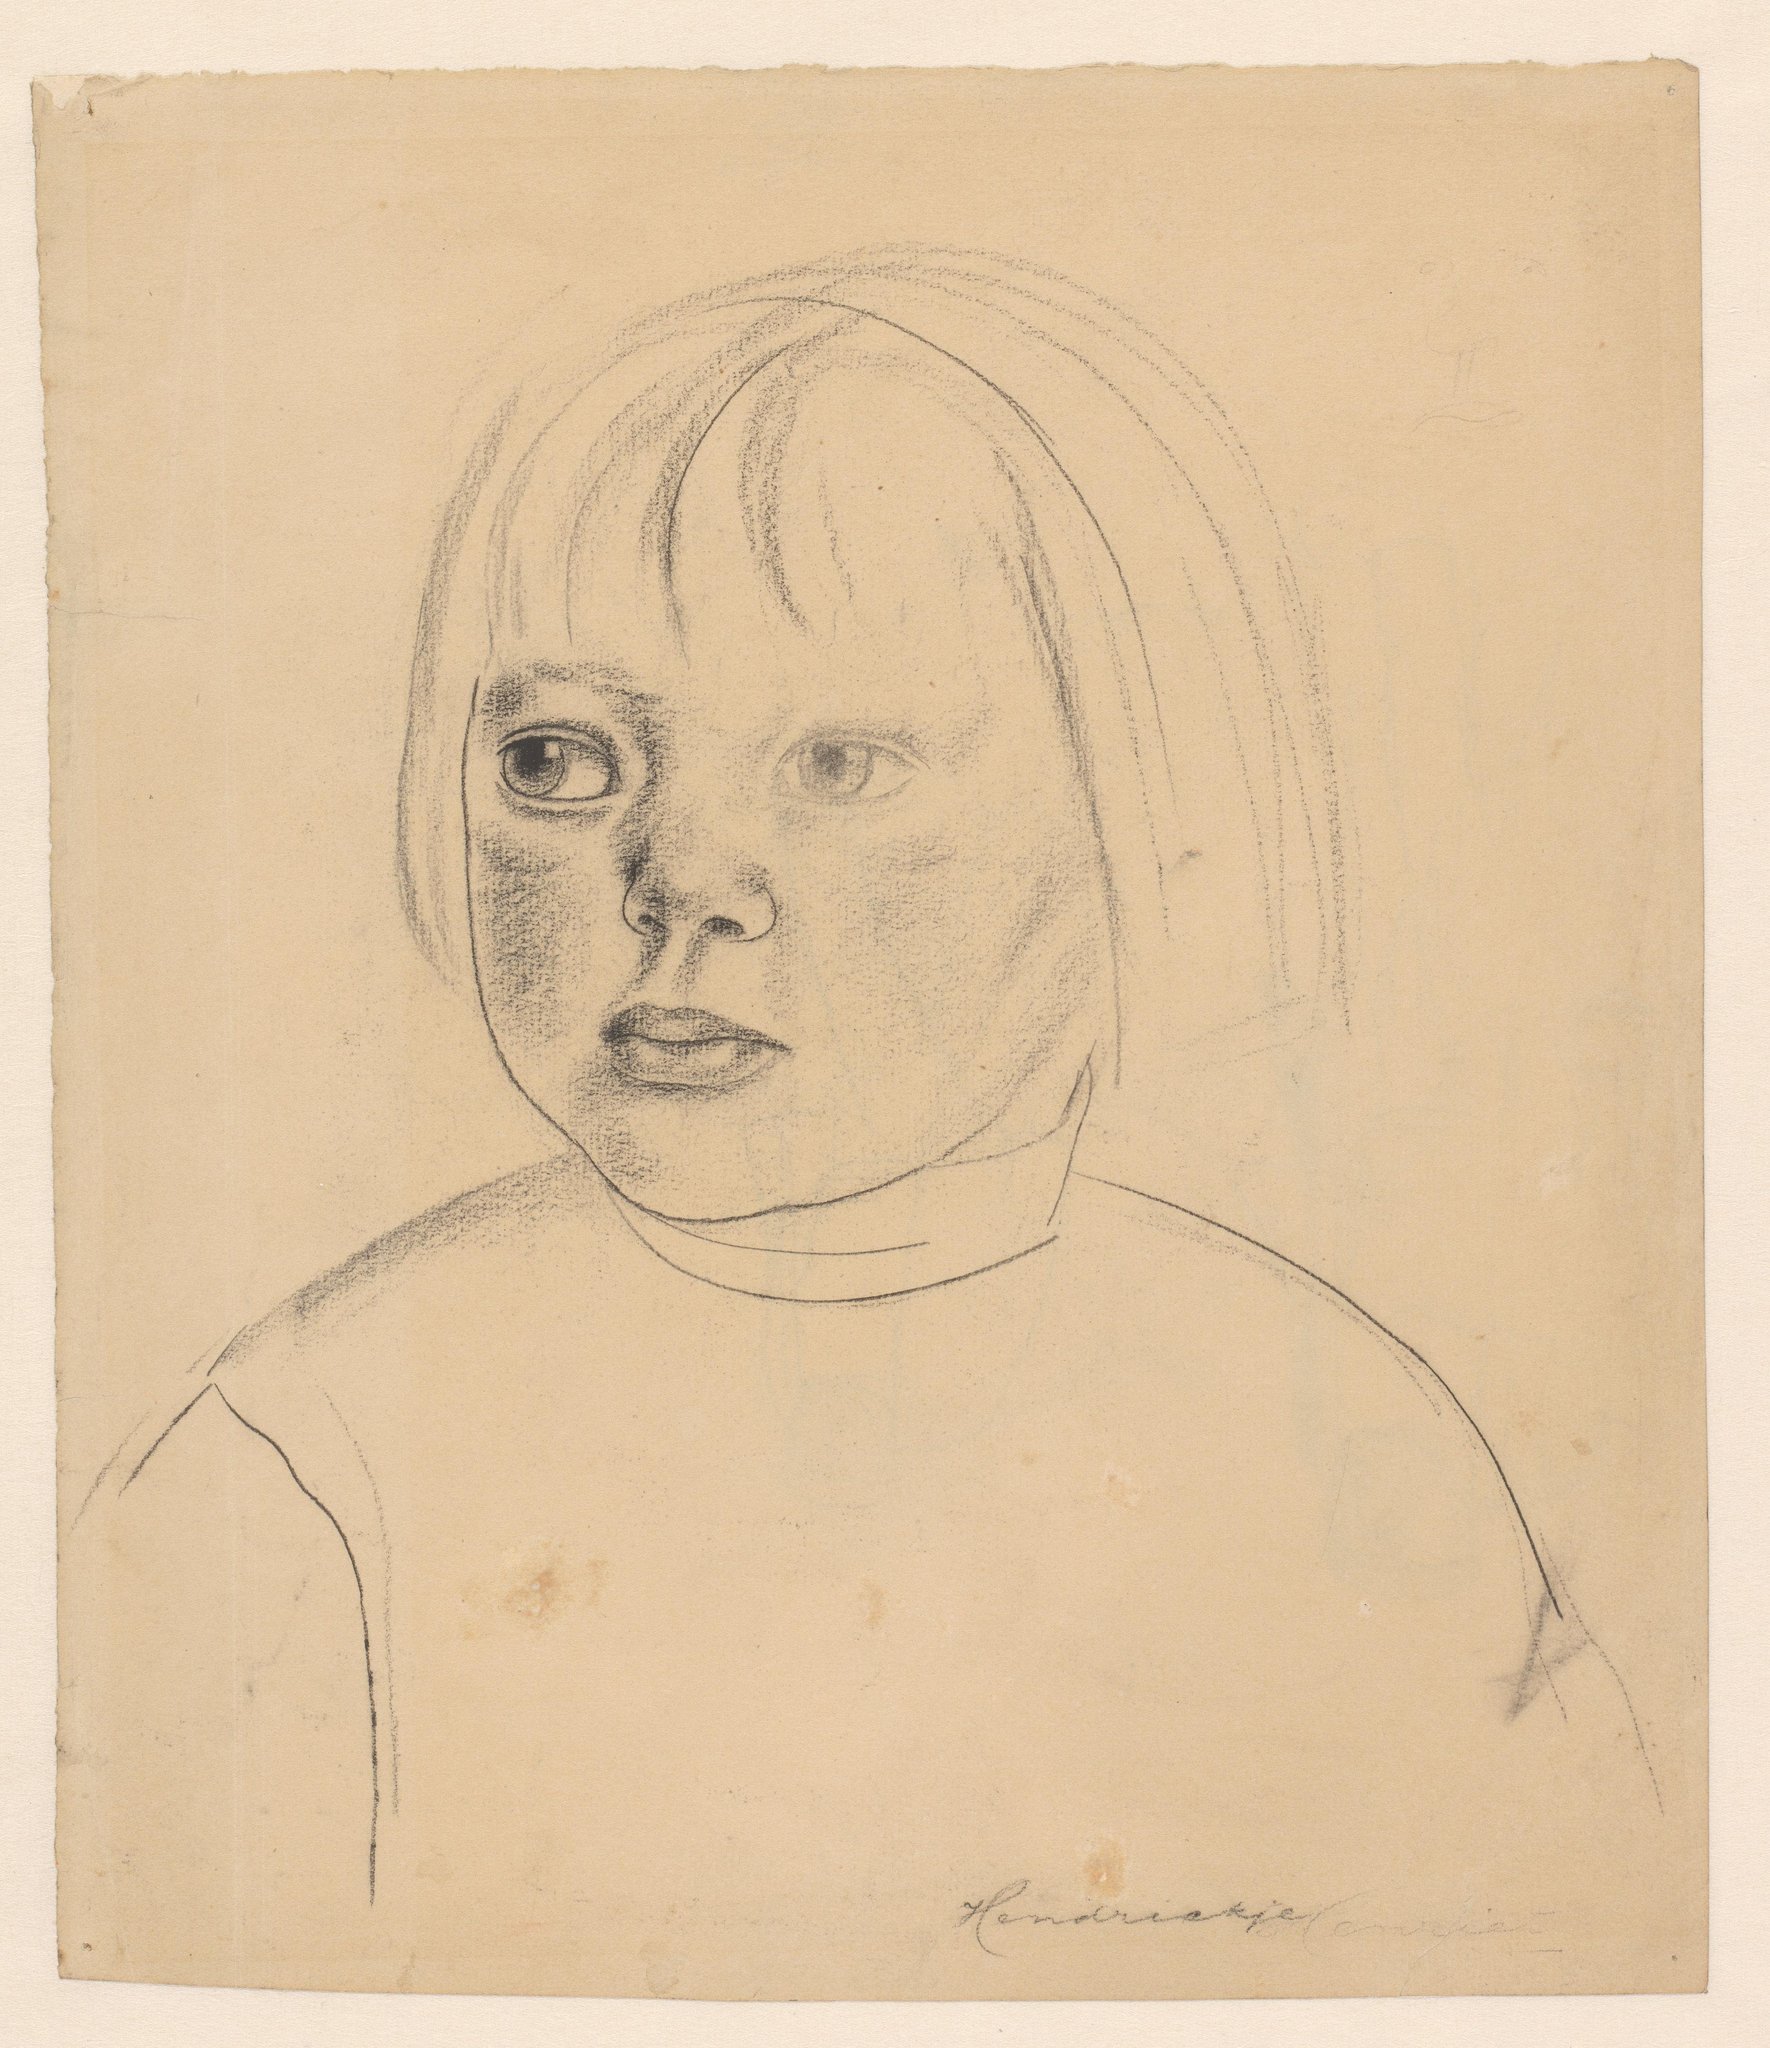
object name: drawing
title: Hendrickje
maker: henk henriët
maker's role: draughtsman, print maker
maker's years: 1903-1945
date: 1913-1945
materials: chalk, paper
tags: historical persons - bb - woman, child (at home) - aa - girl